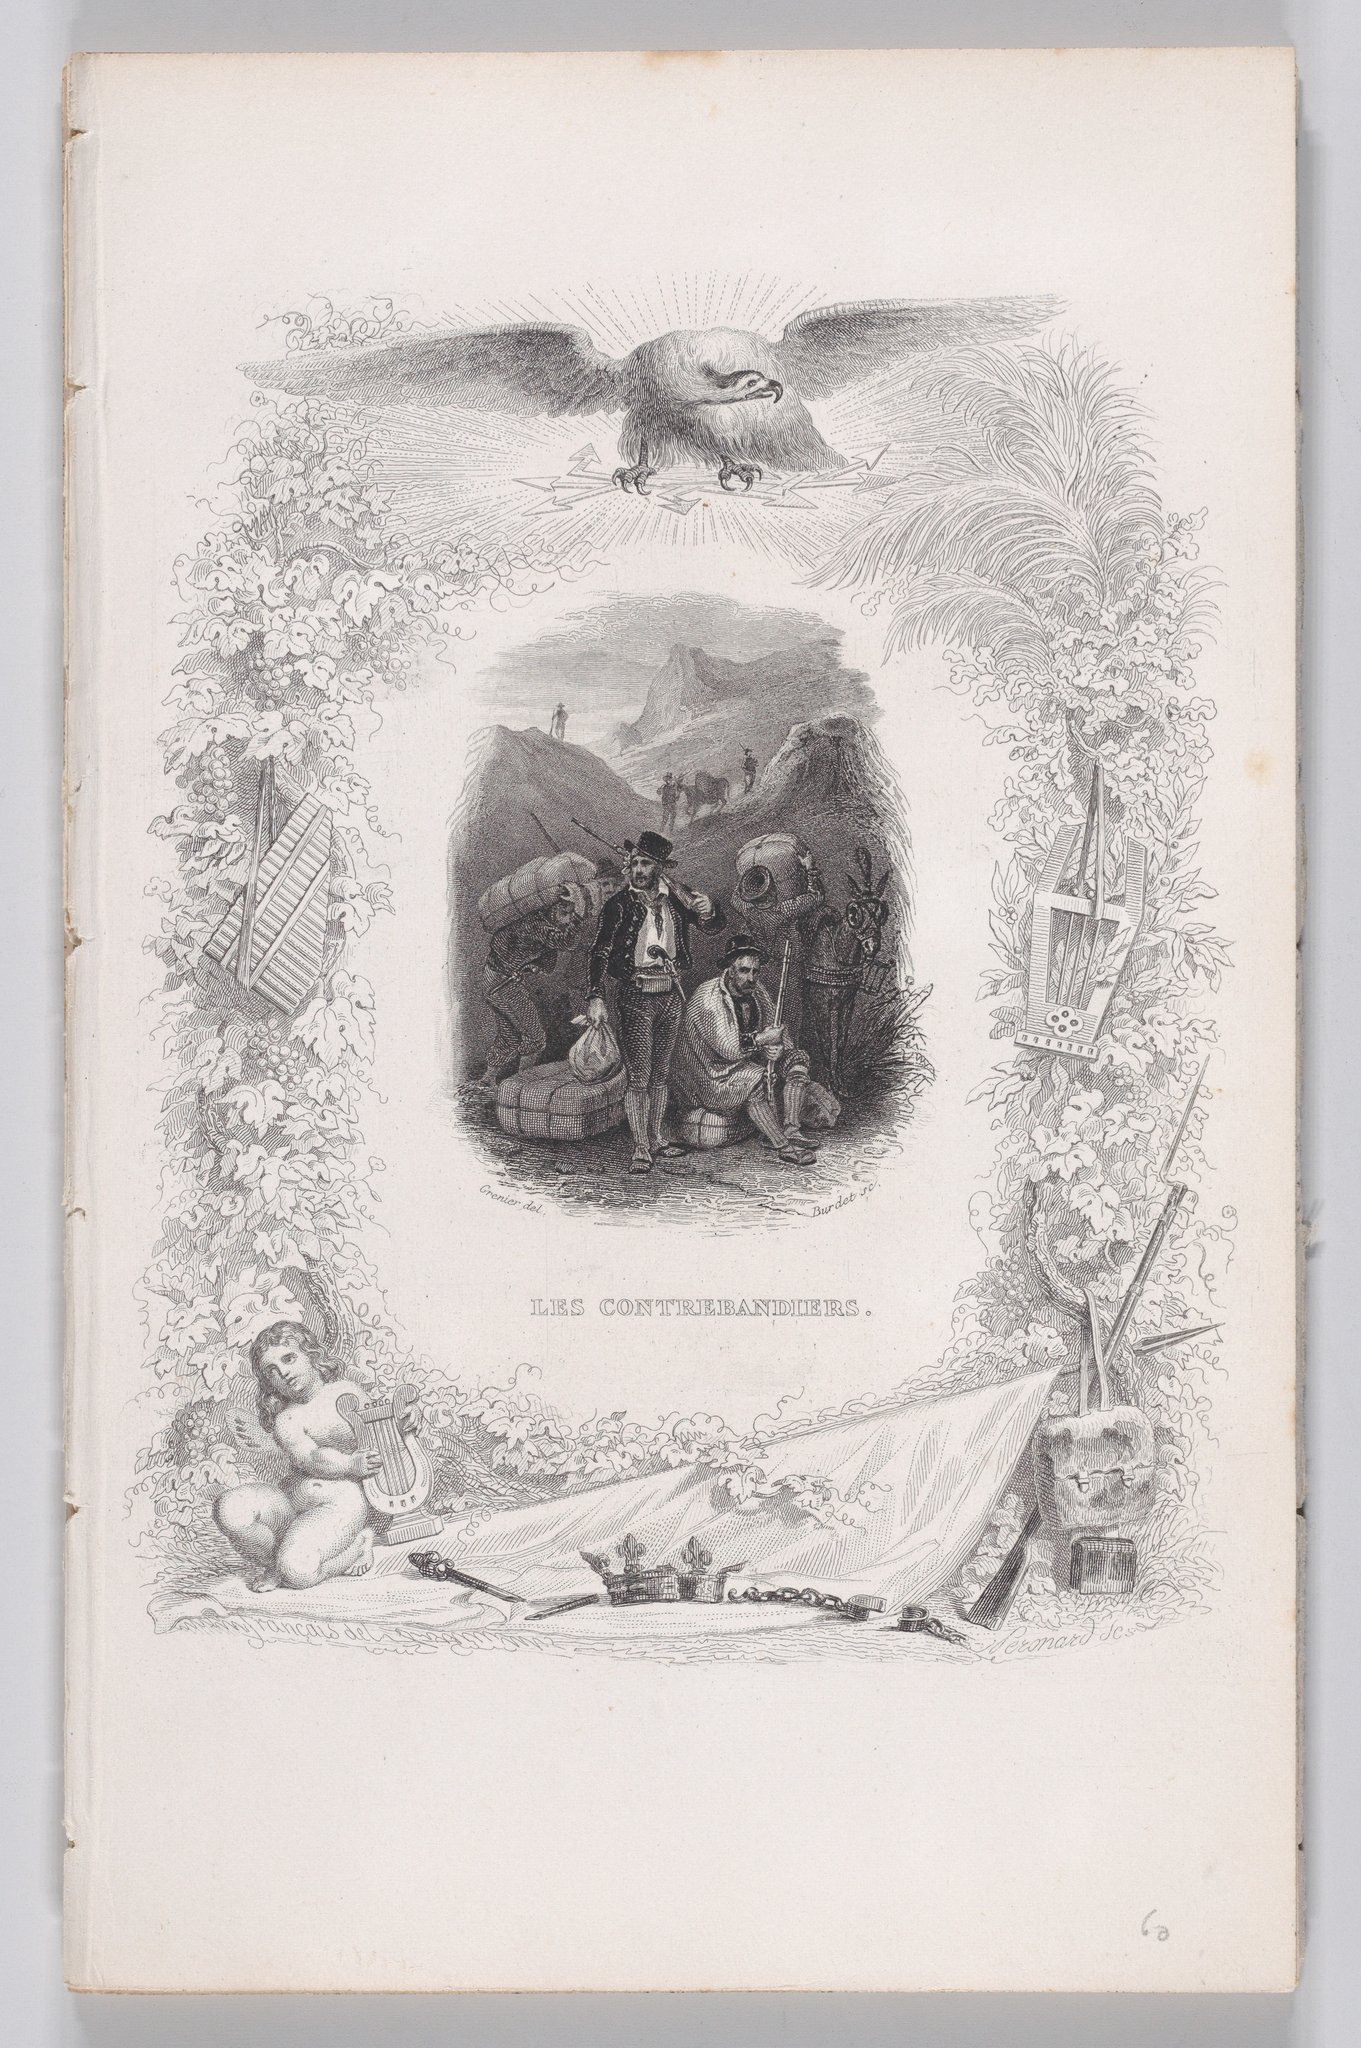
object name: print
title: The Smugglers, from "The Songs of Béranger"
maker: augustin burdet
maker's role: engraver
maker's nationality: french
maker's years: 1798-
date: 1829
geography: paris